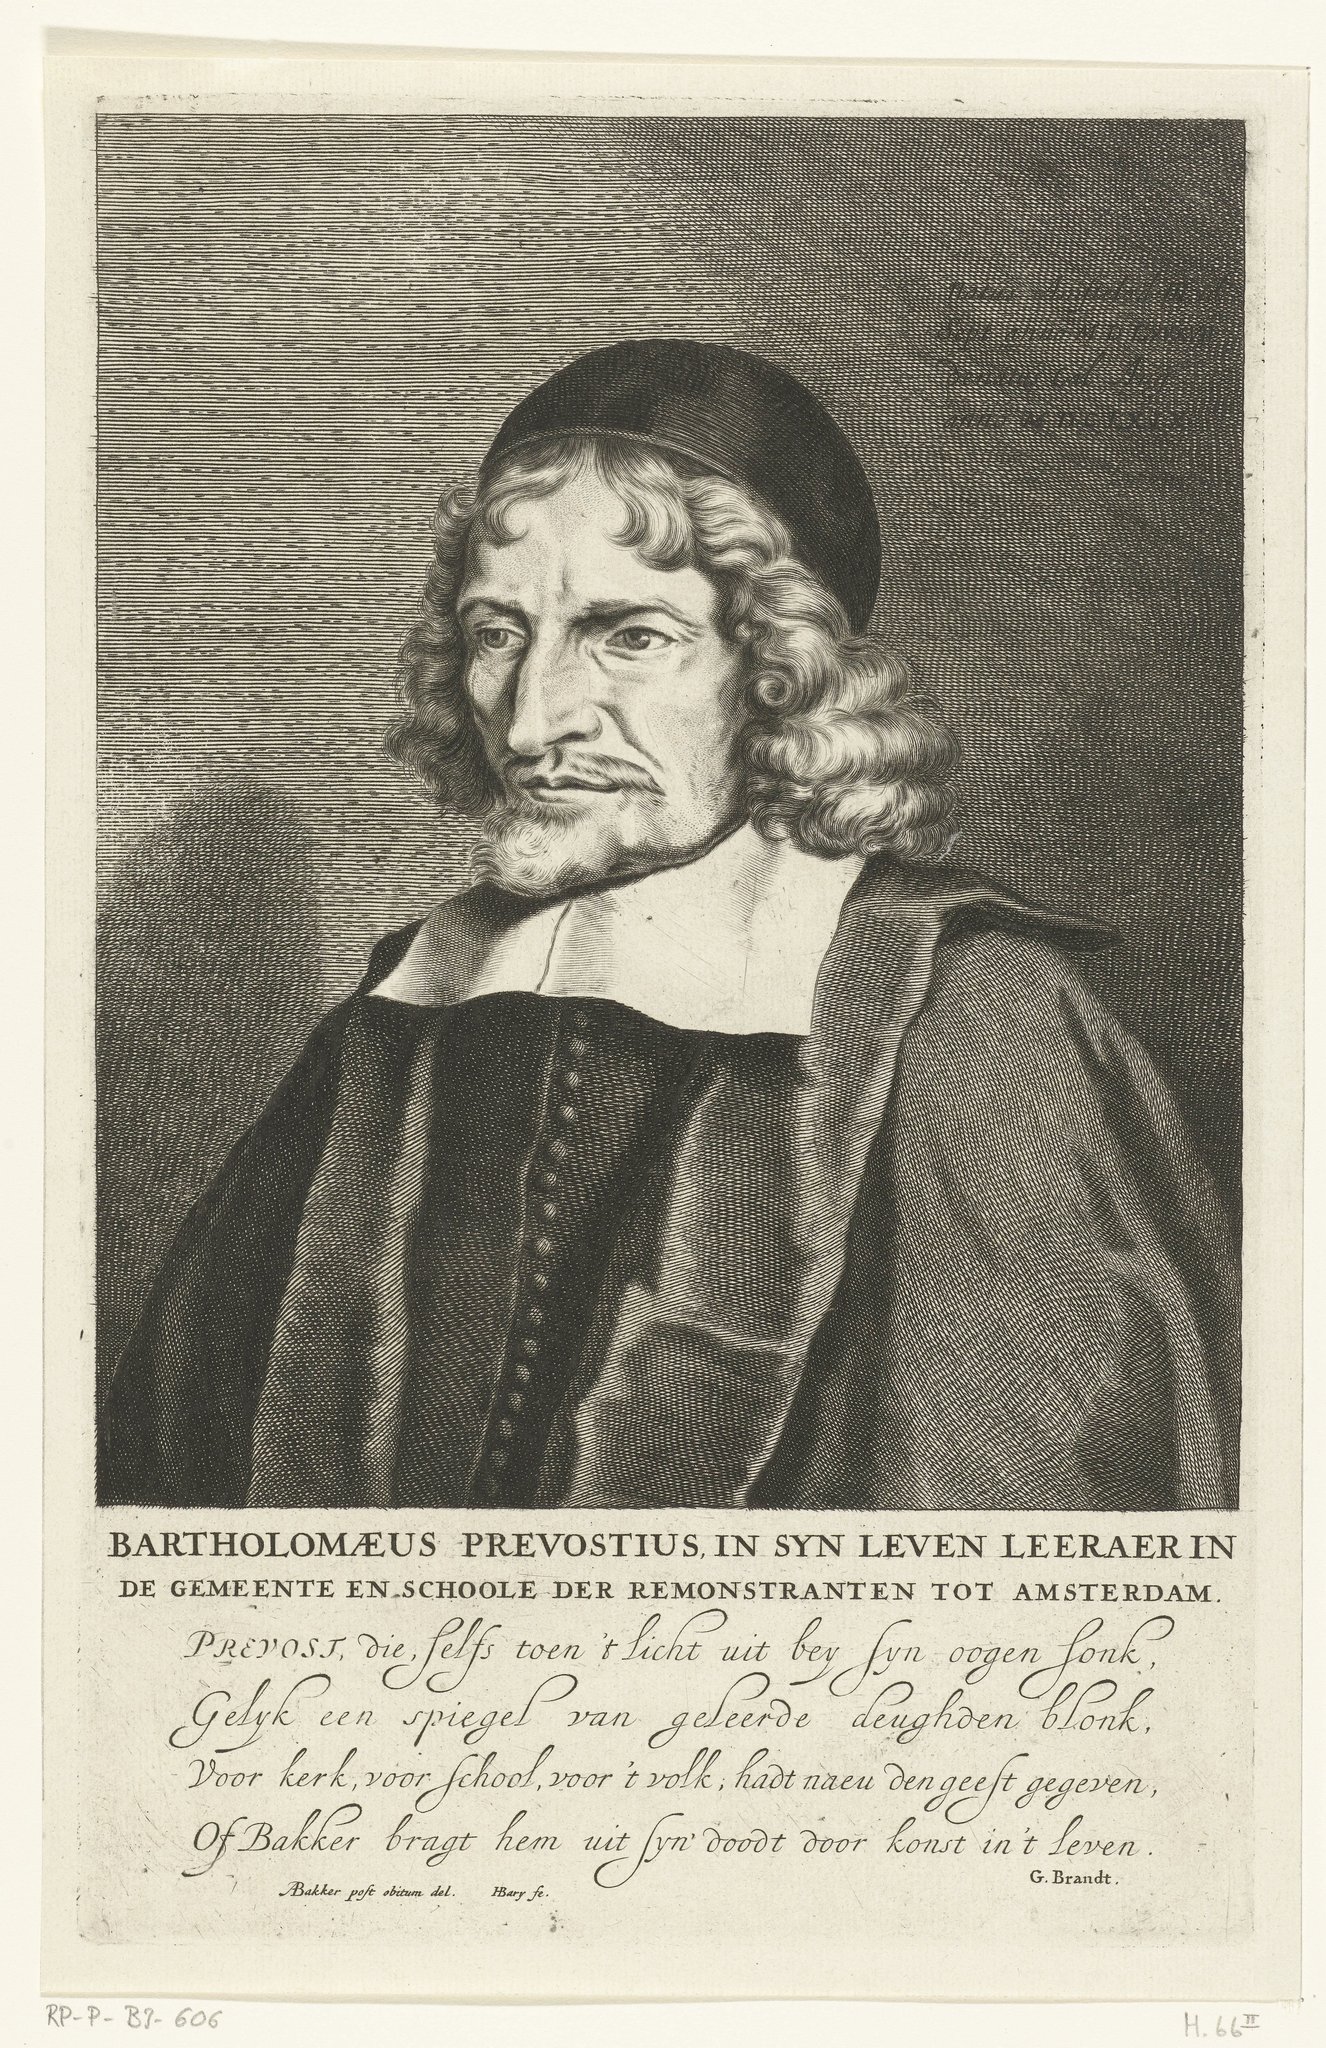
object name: print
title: Portret van Bartholomaeus Prevostius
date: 1669-1707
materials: paper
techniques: engraving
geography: netherlands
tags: predikant, bartholomaeus prevostius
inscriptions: collector's mark: Lugt 2228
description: Borstbeeld van de remonstrantse predikant Bartholomaeus Prevostius. Onder het portret een vers van vier regels in het Nederlands door G. Brandt.